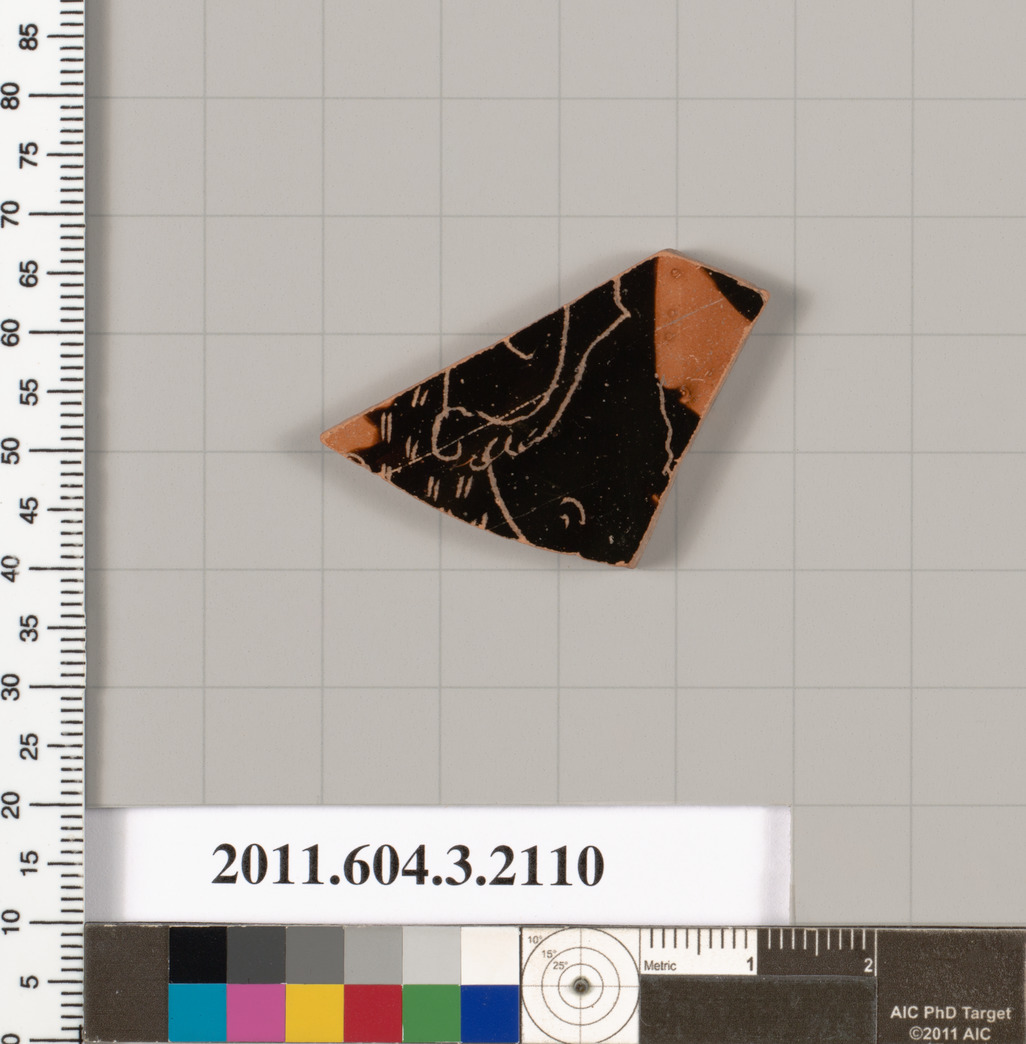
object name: kylix fragment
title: Terracotta fragment of a kylix (drinking cup)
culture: greek, attic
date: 525-501 BCE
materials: terracotta